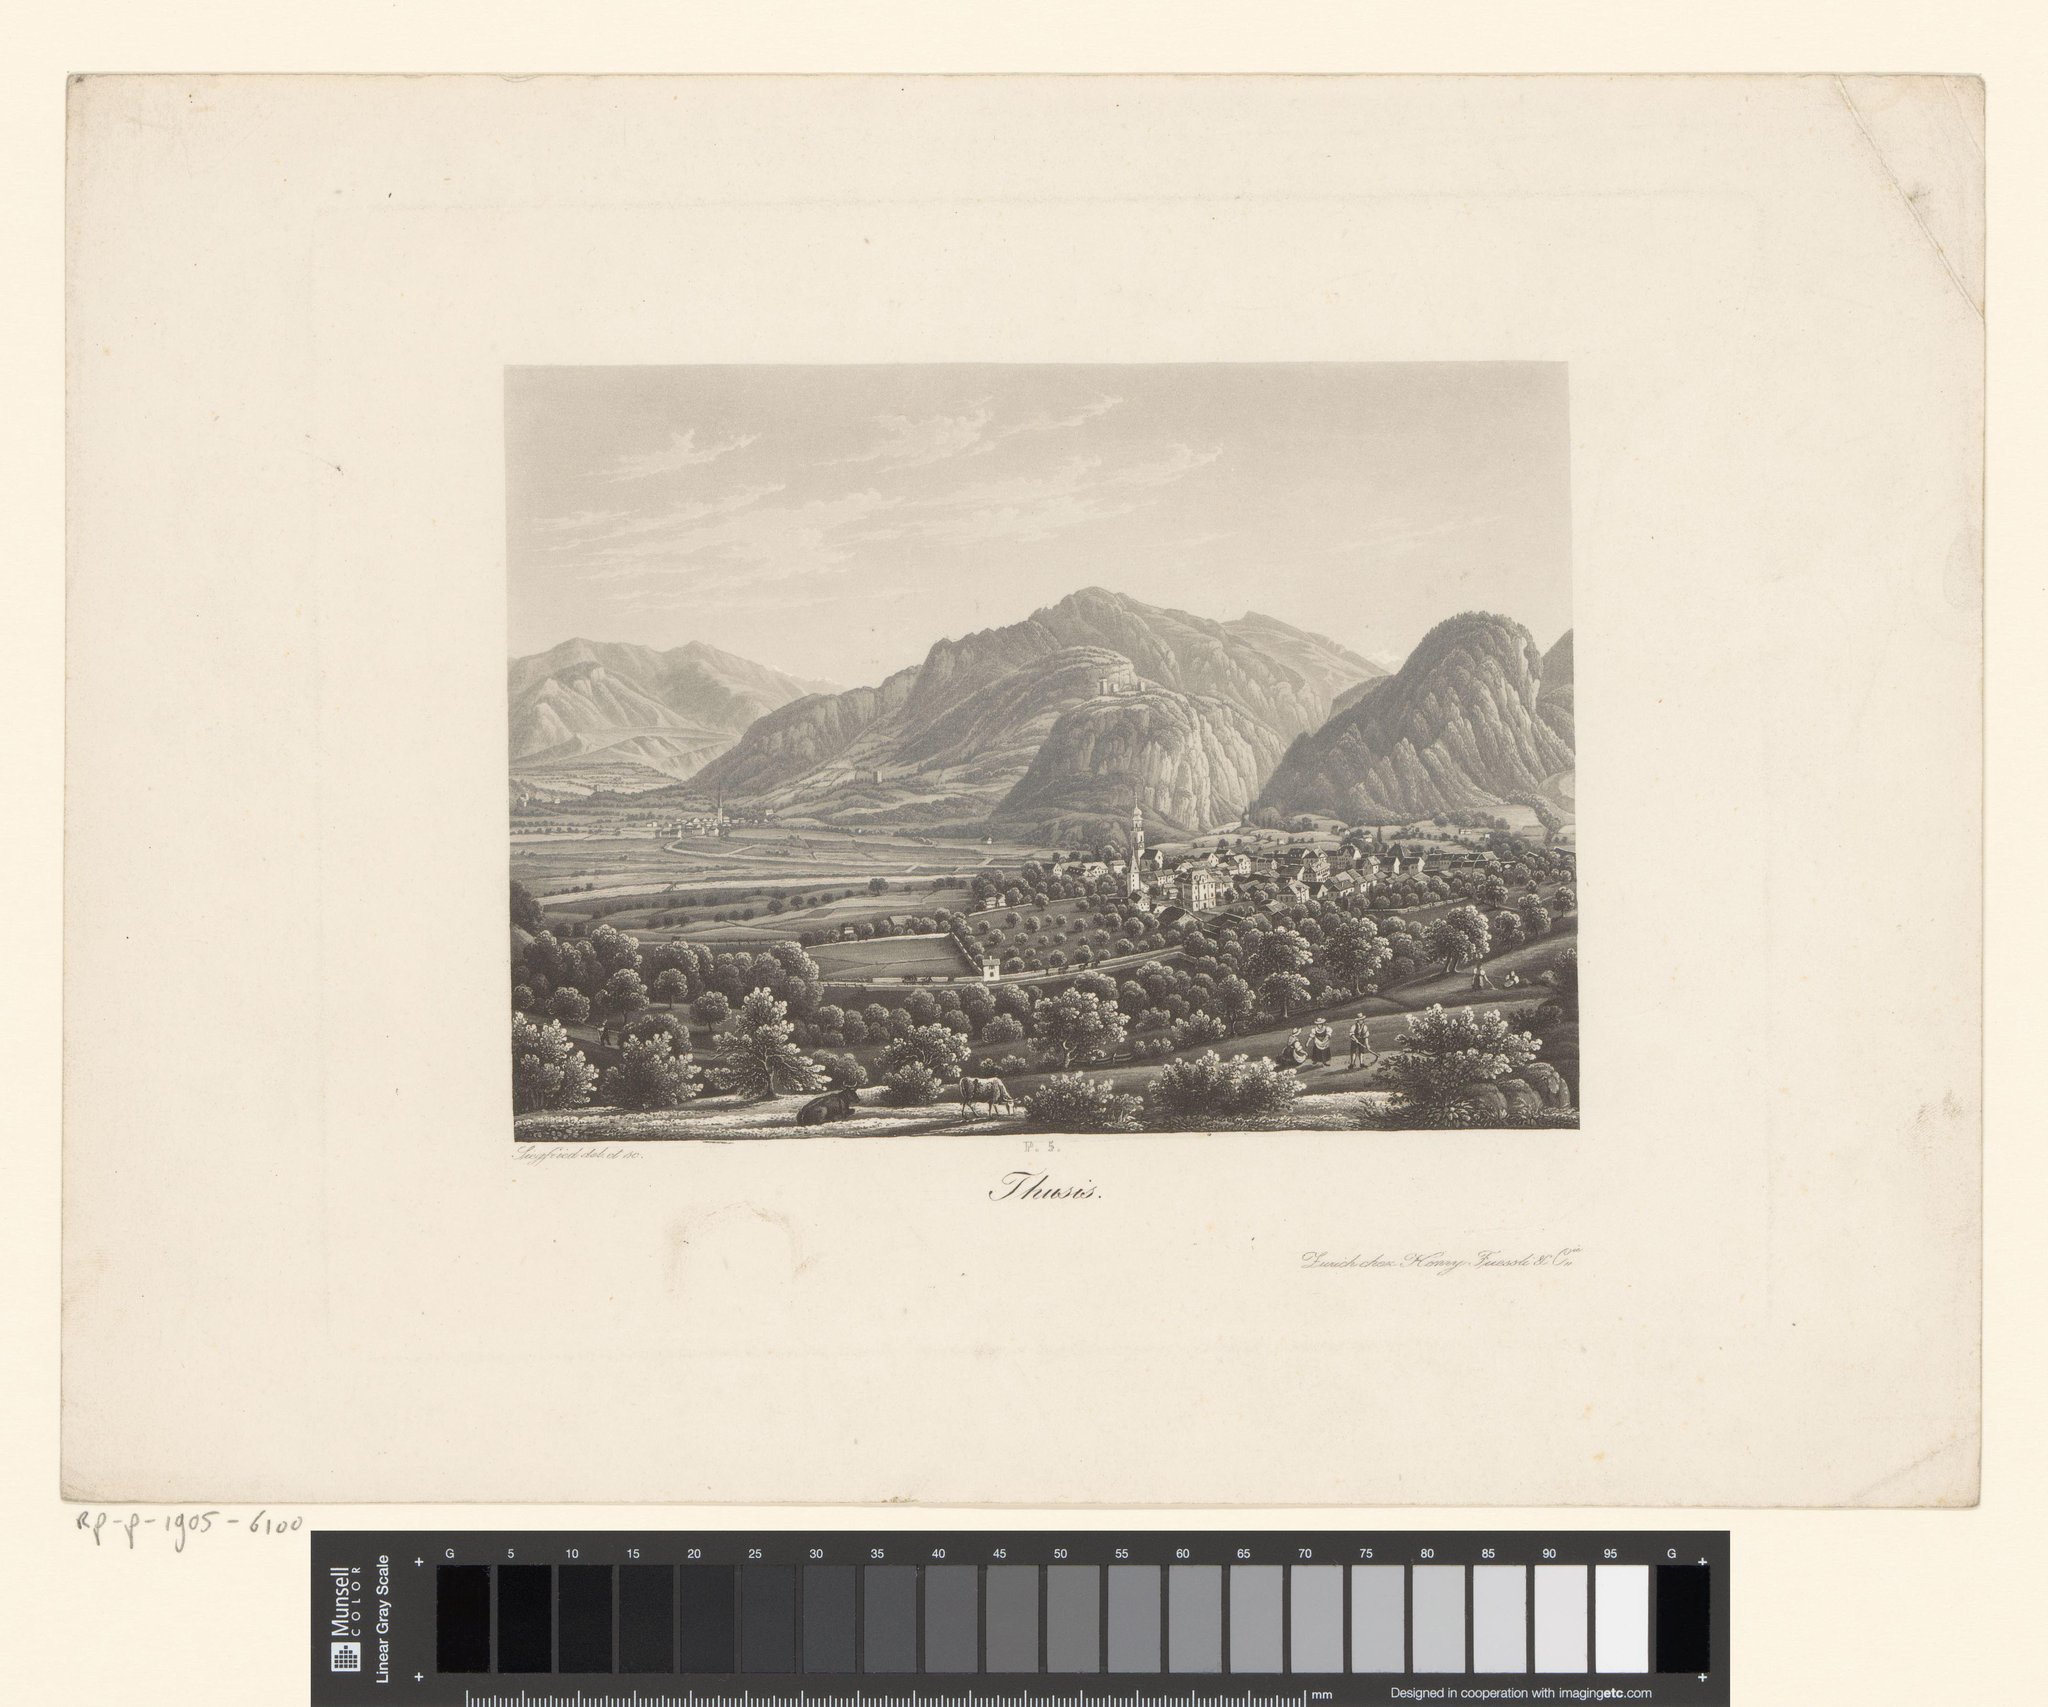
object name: print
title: Thusis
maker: heinrich siegfried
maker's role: print maker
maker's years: 1814-1889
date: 1824-1889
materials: paper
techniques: aquatint, etching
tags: landscapes, mountains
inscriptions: collector's mark: Lugt 2228